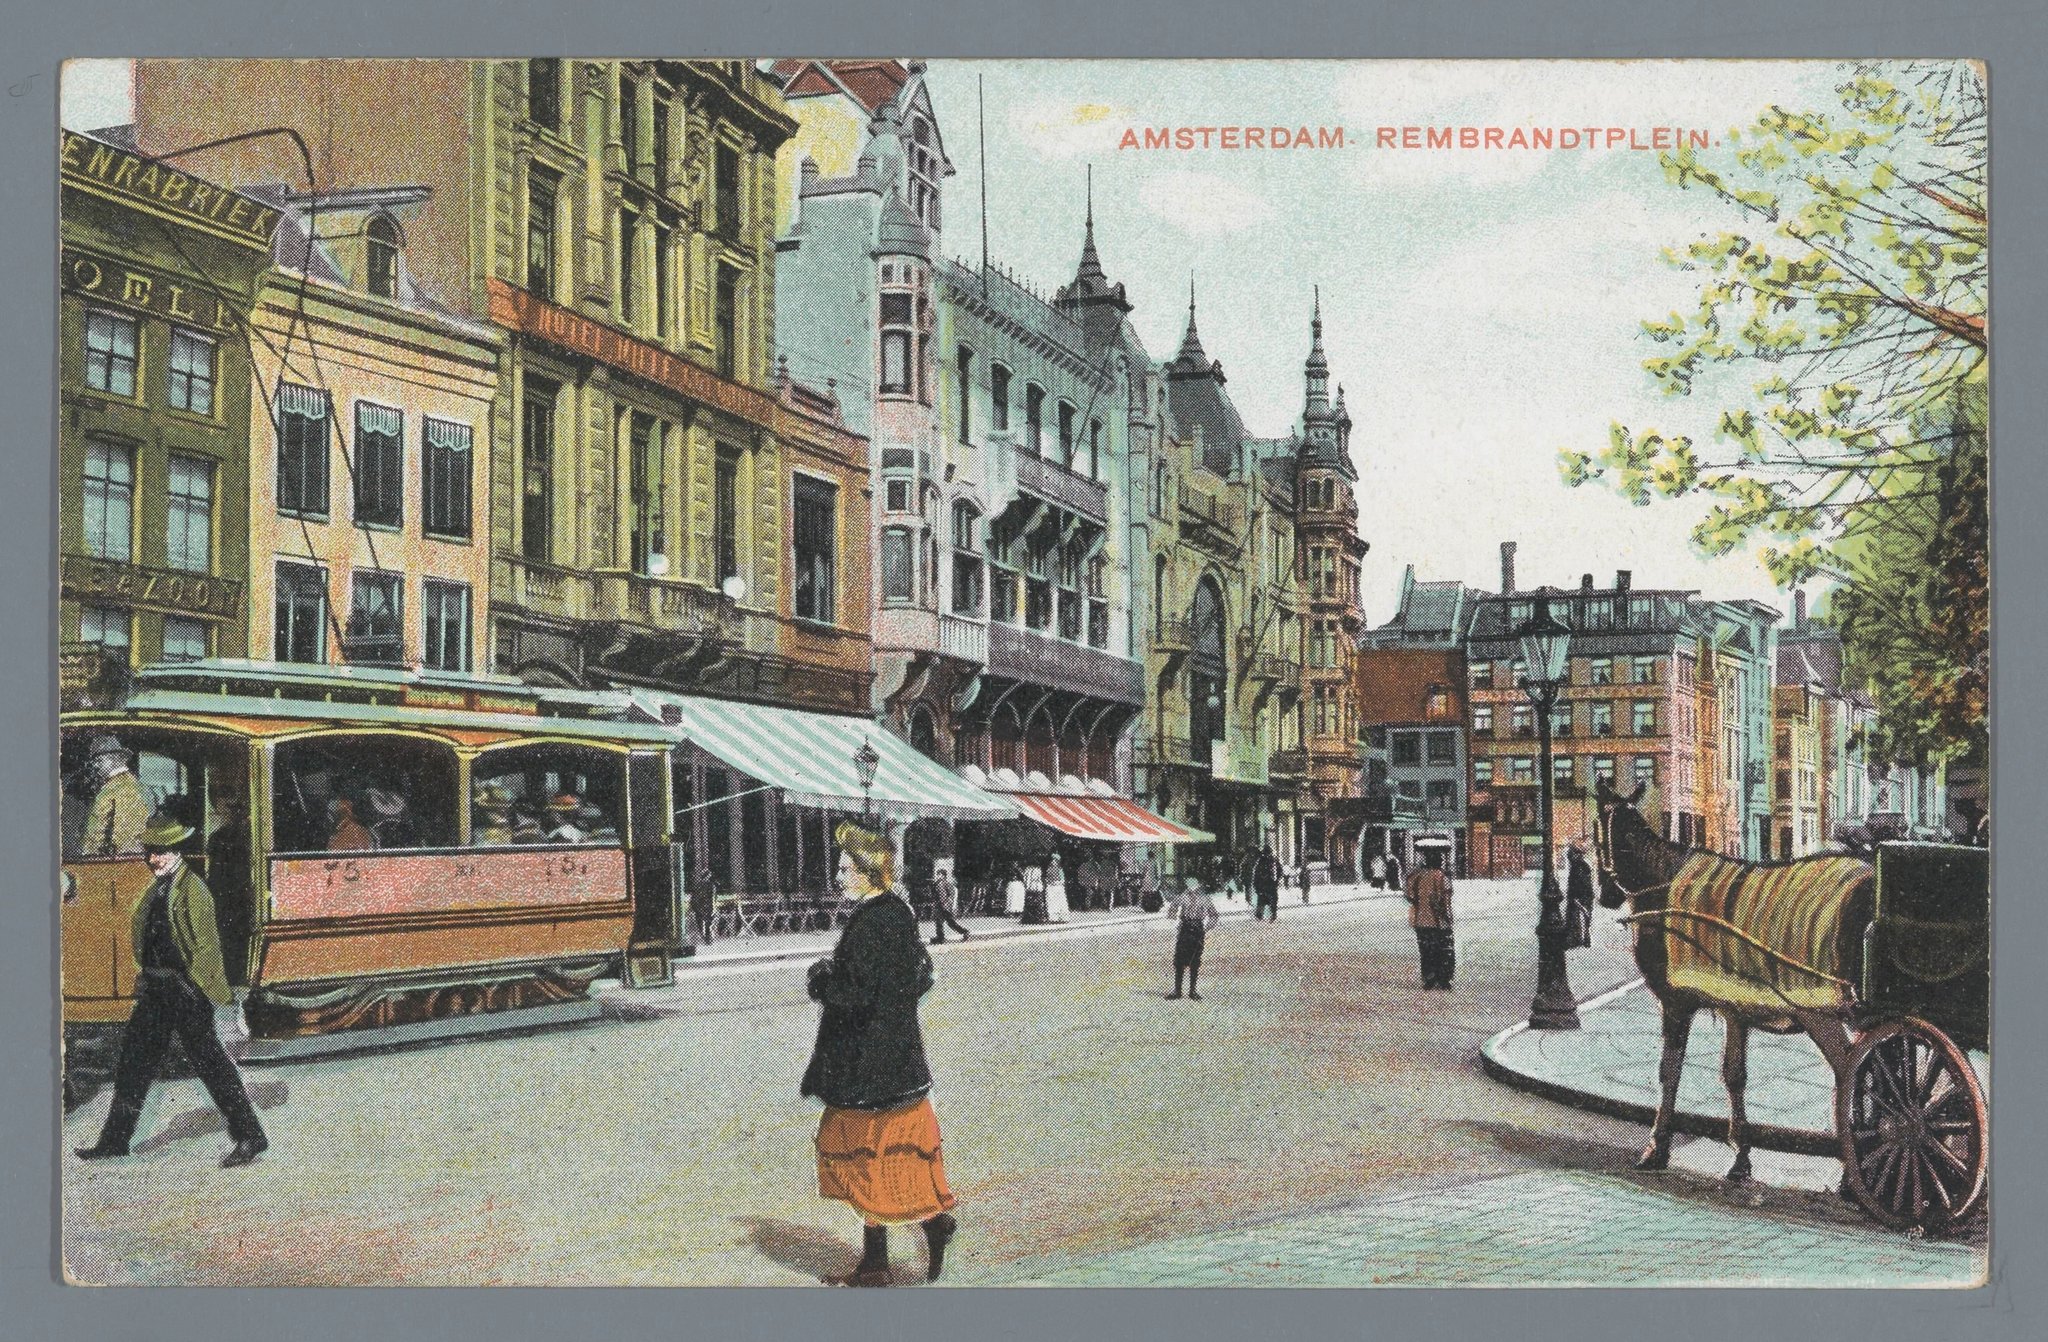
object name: photomechanical print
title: Amsterdam, Rembrandtplein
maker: Anonymous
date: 1875-1930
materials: cardboard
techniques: writing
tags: square, place, circus, etc.